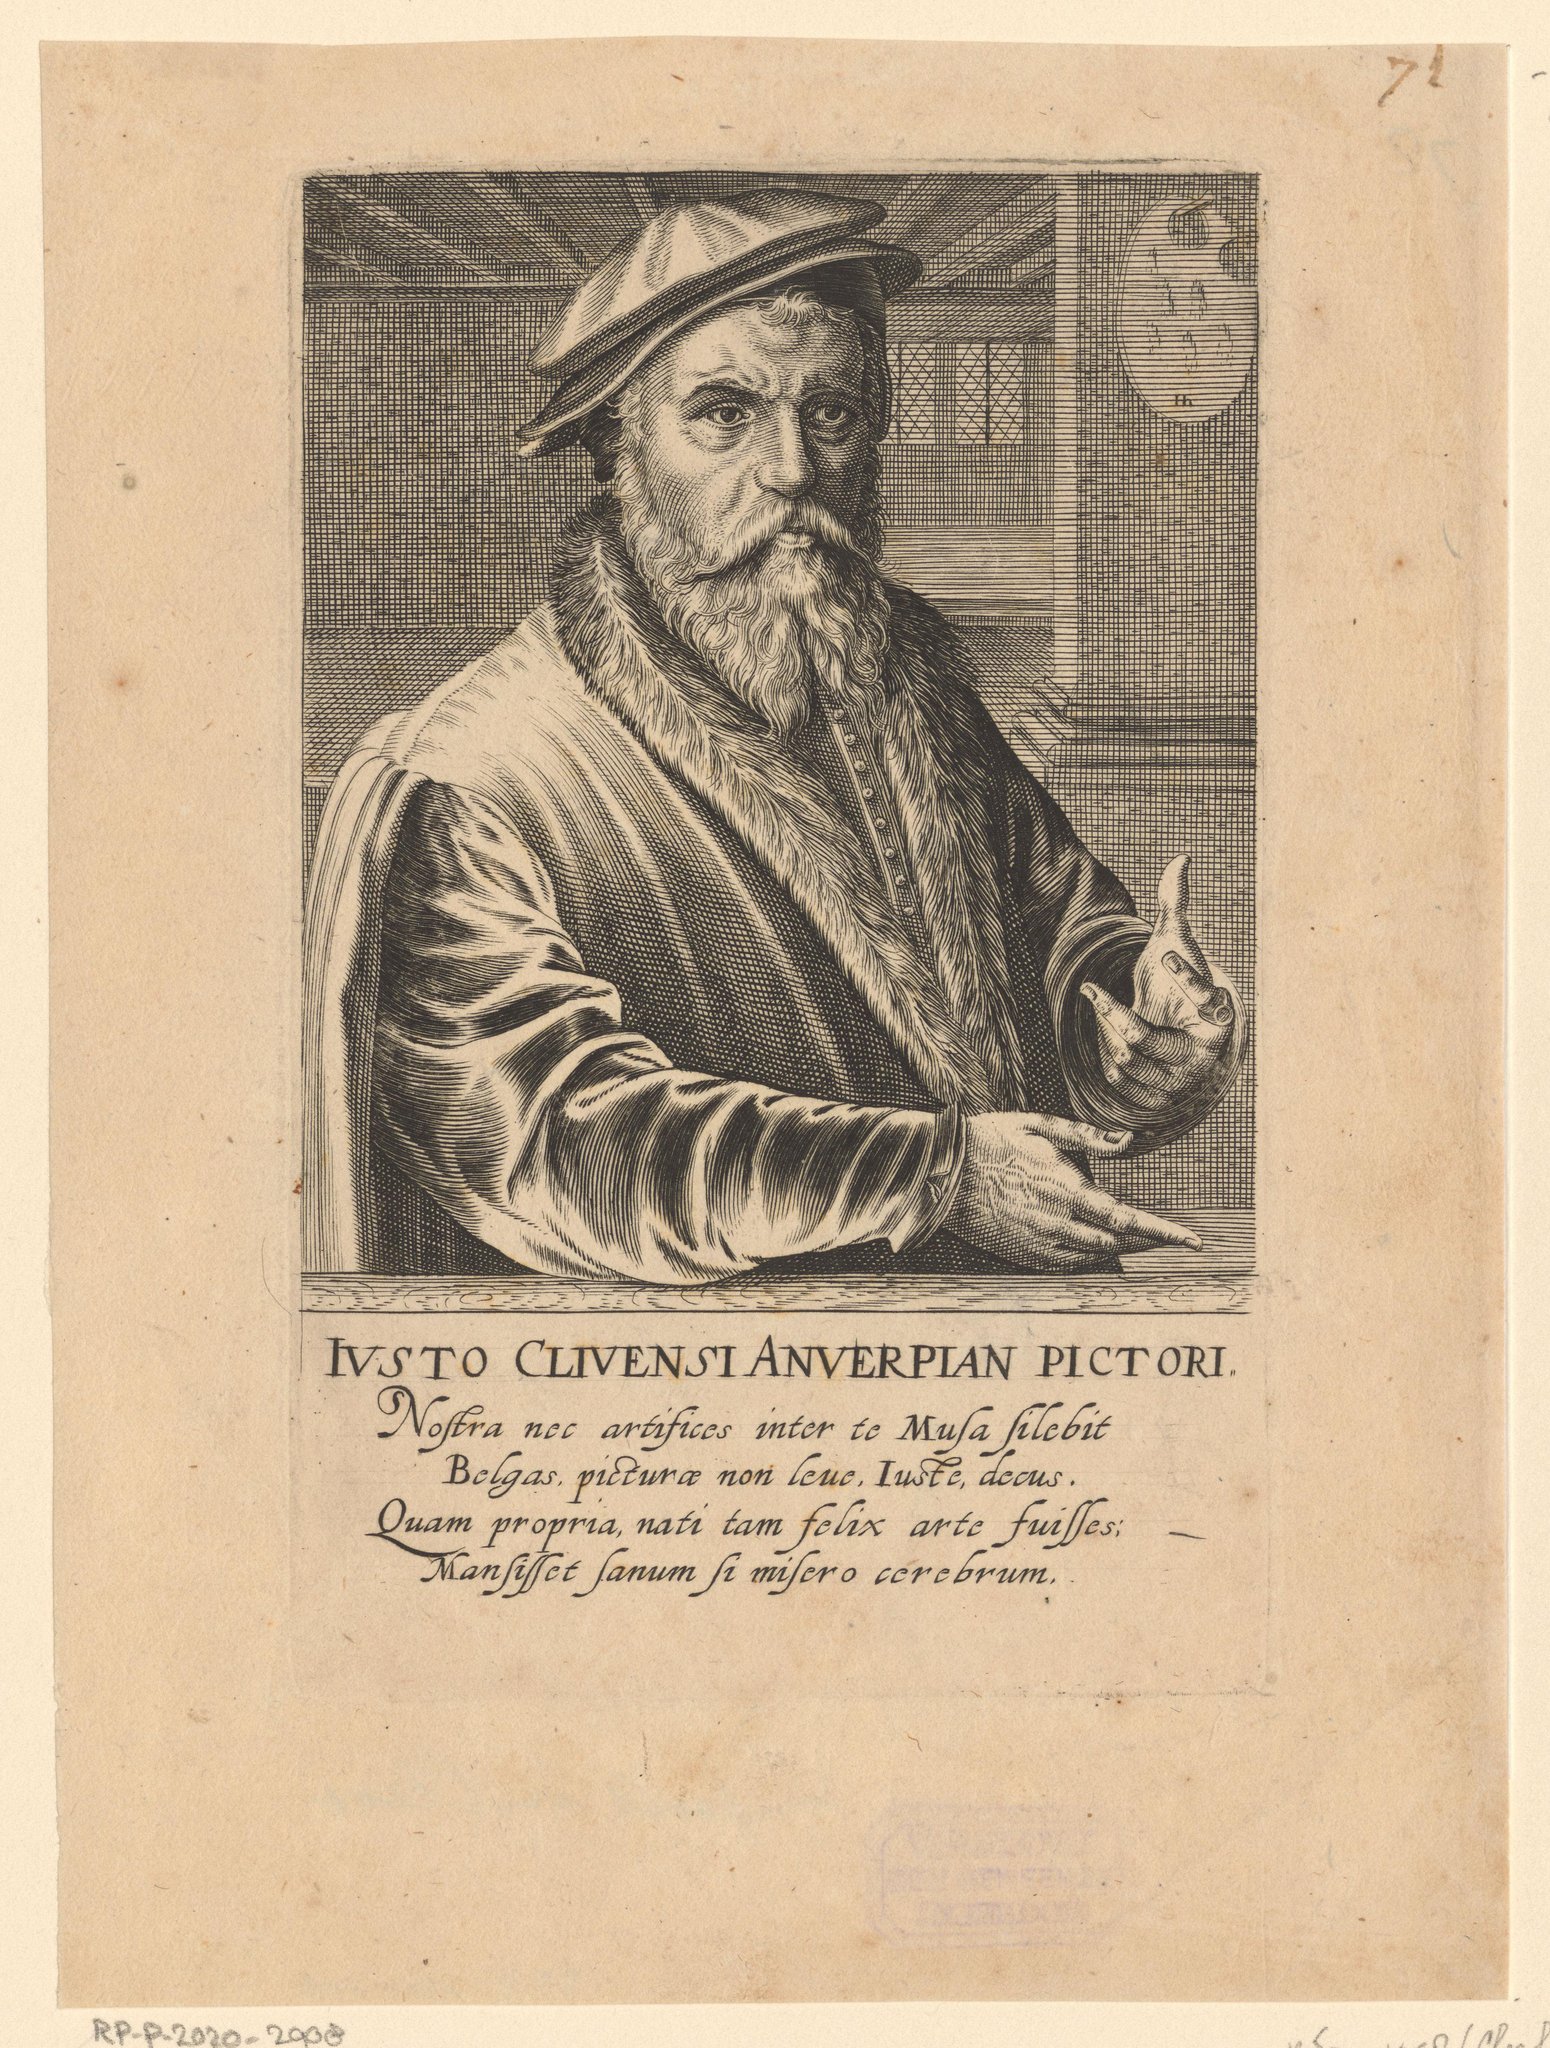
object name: print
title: Portret van Joos van Cleve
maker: hendrick hondius (i)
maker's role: draughtsman, print maker, publisher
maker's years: 1573-1650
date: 1610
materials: paper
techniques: engraving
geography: the hague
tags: cleves, joos van cleve, historical persons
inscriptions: collector's mark: Lugt 11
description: Prent mogelijk uit: Pictorum aliquot celebrium praecipué Germaniae inferioris (...). Den Haag: Hendrick Hondius I, 1610. Of uit latere editie (1612, 1618).